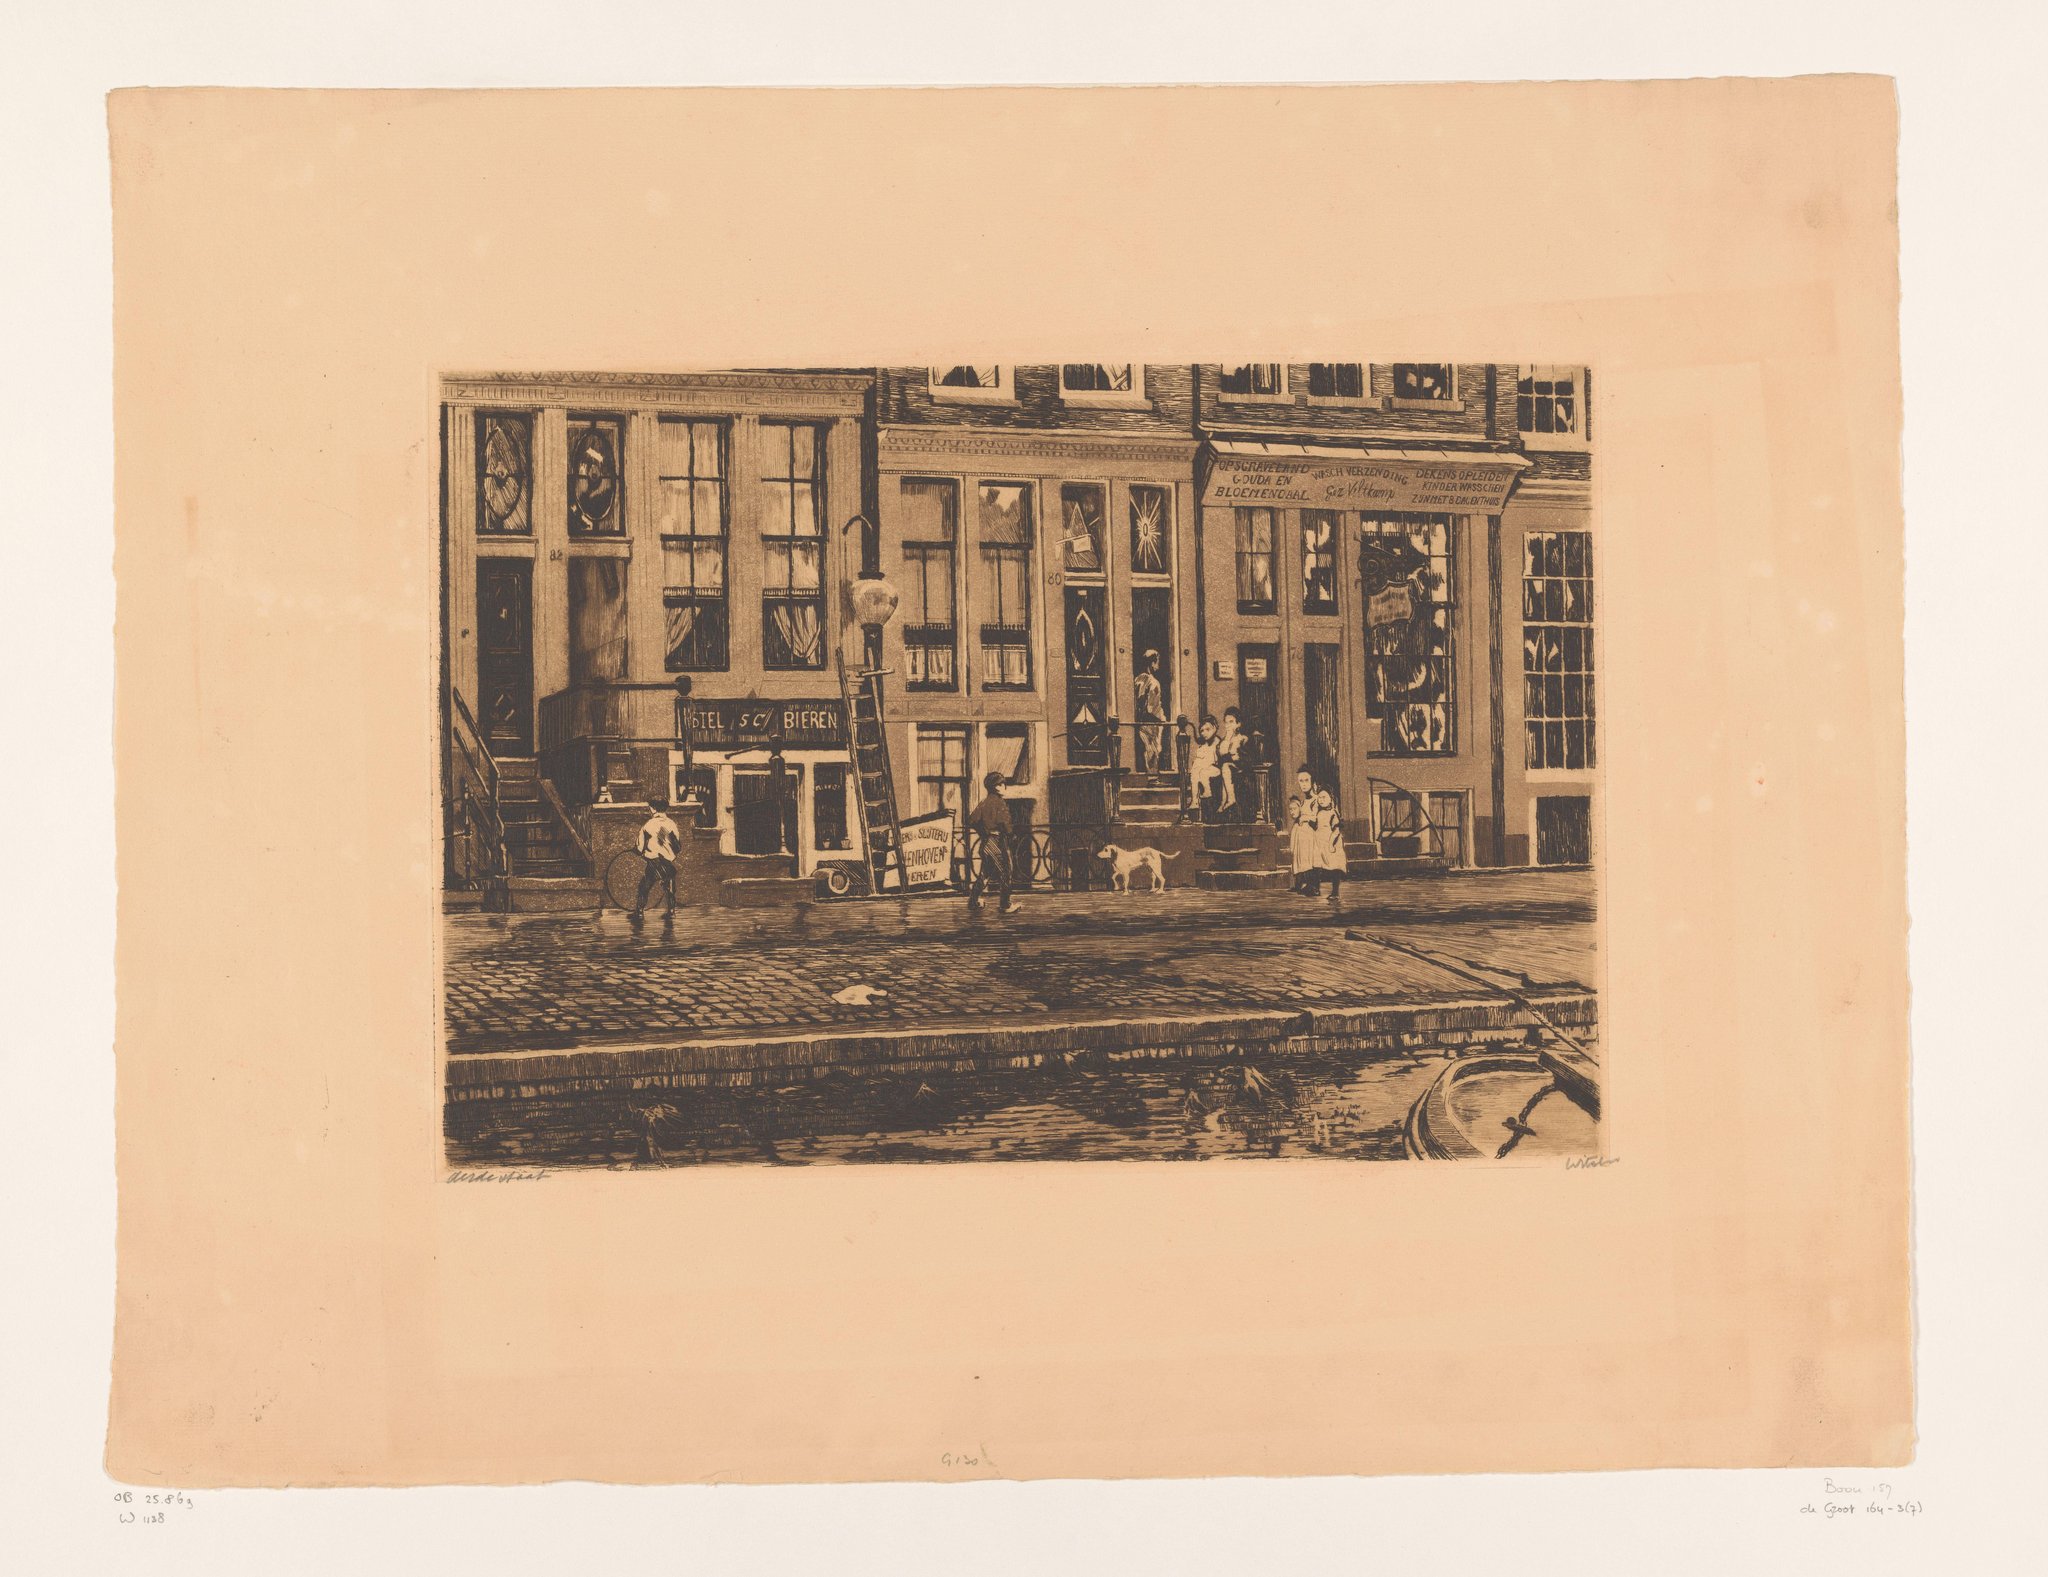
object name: print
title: Oude Waal met de wasinrichting van de gezusters Veltkamp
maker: willem witsen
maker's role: draughtsman, painter, print maker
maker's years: 1860-1923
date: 1912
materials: paper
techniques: aquatint, etching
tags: urban housing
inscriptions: annotation: ‘derde staat’